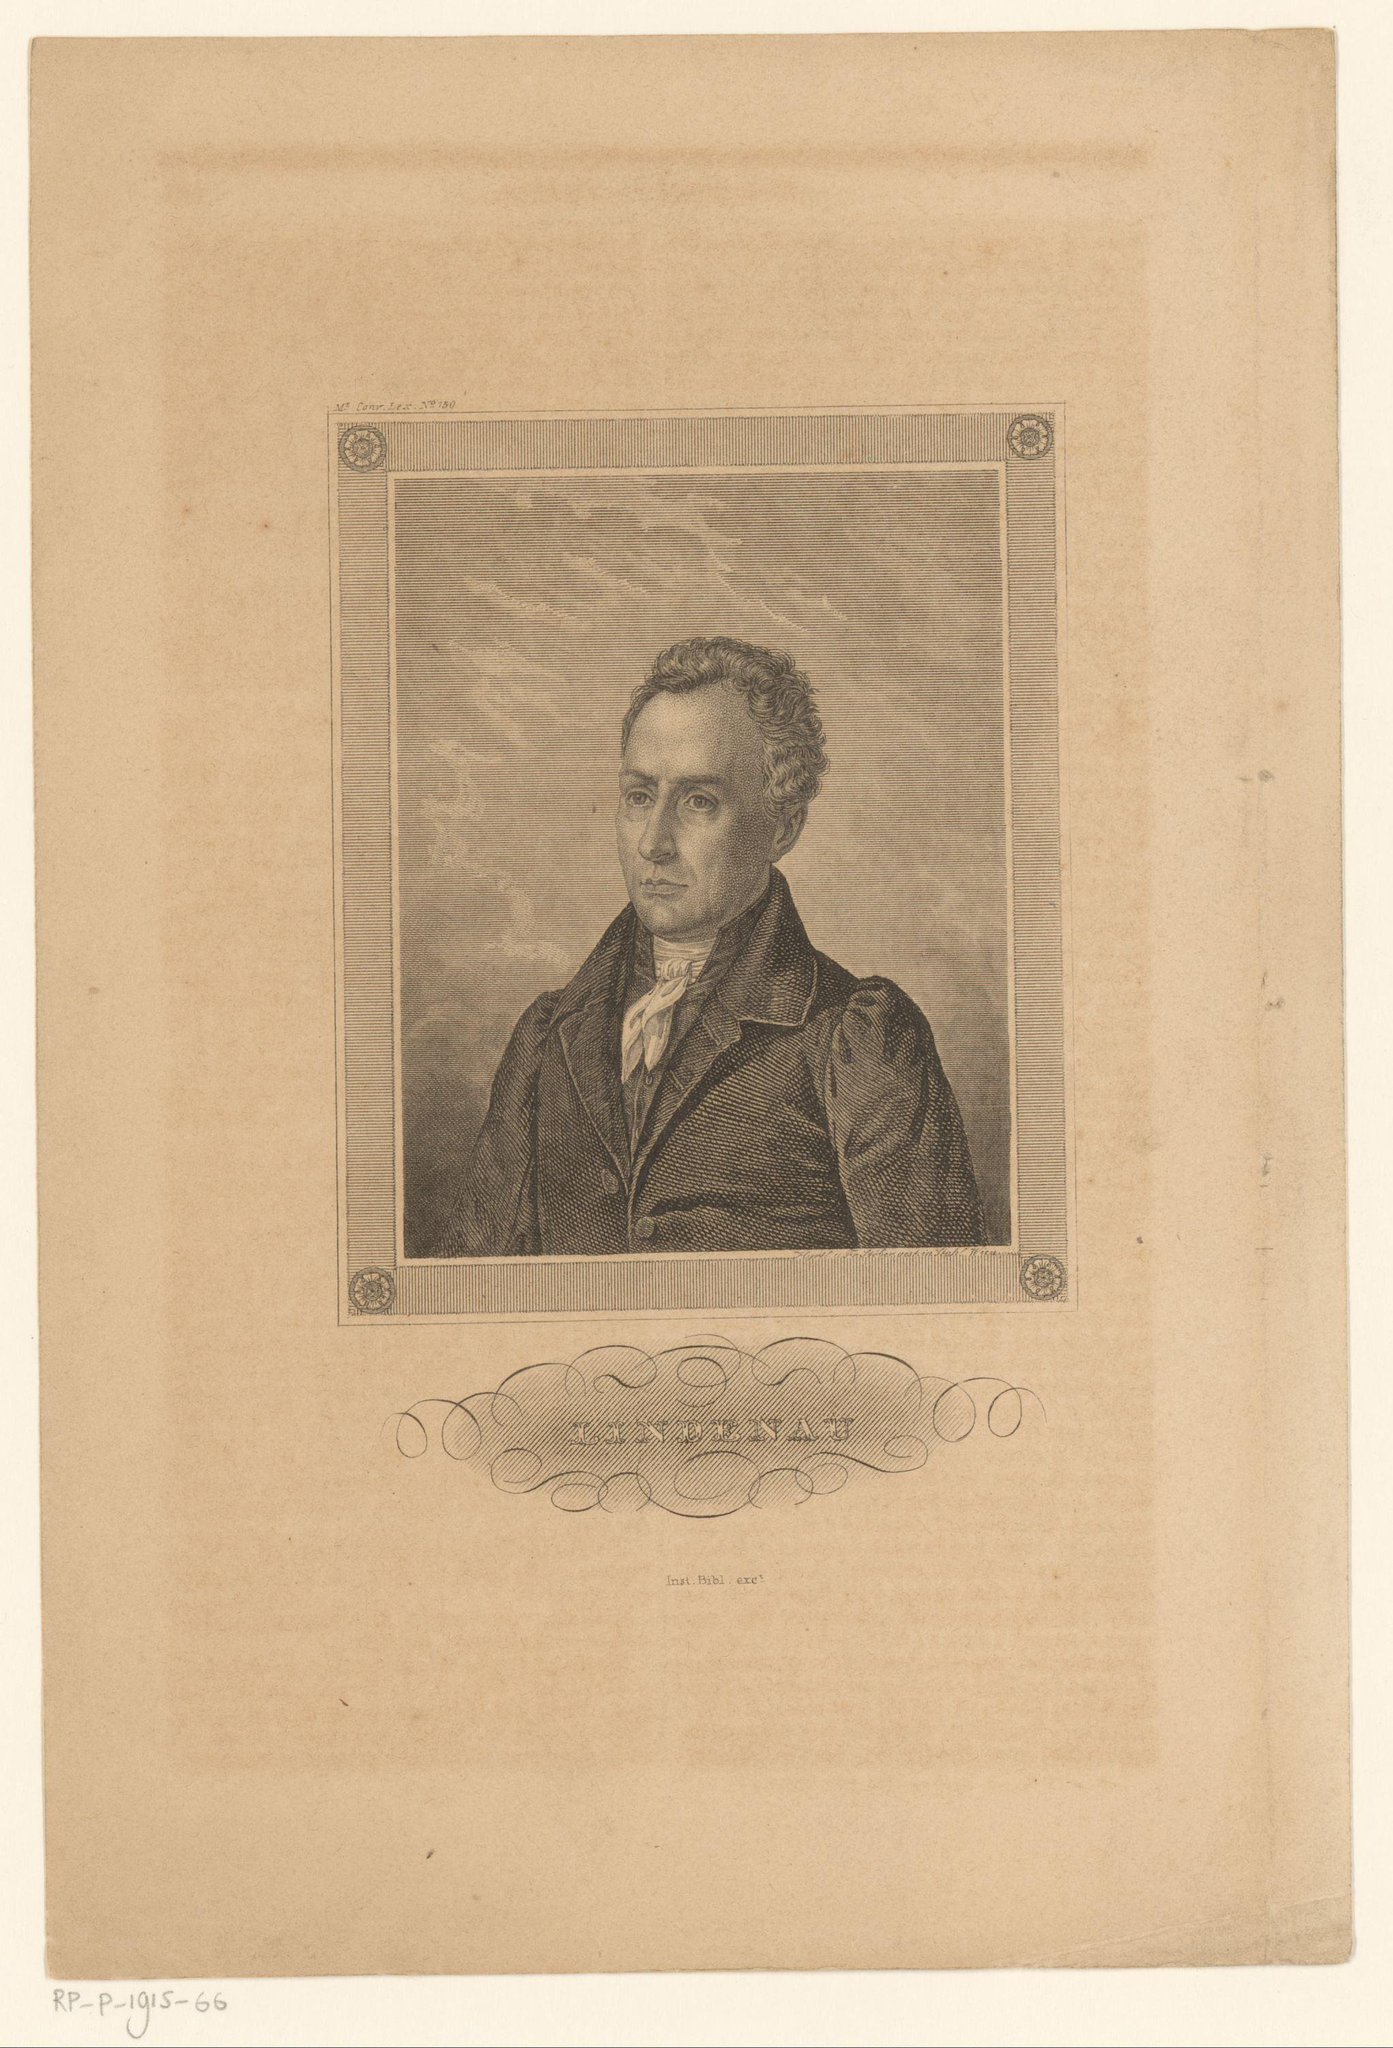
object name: print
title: Portret van Bernhard August von Lindenau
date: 1840-1855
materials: paper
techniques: engraving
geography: vienna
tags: historical persons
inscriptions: collector's mark: Lugt 2228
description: Prent afkomstig uit: Conversations-Lexikon für die gebildeten Stände, voor het eerst uitgegeven tussen 1840-1855.